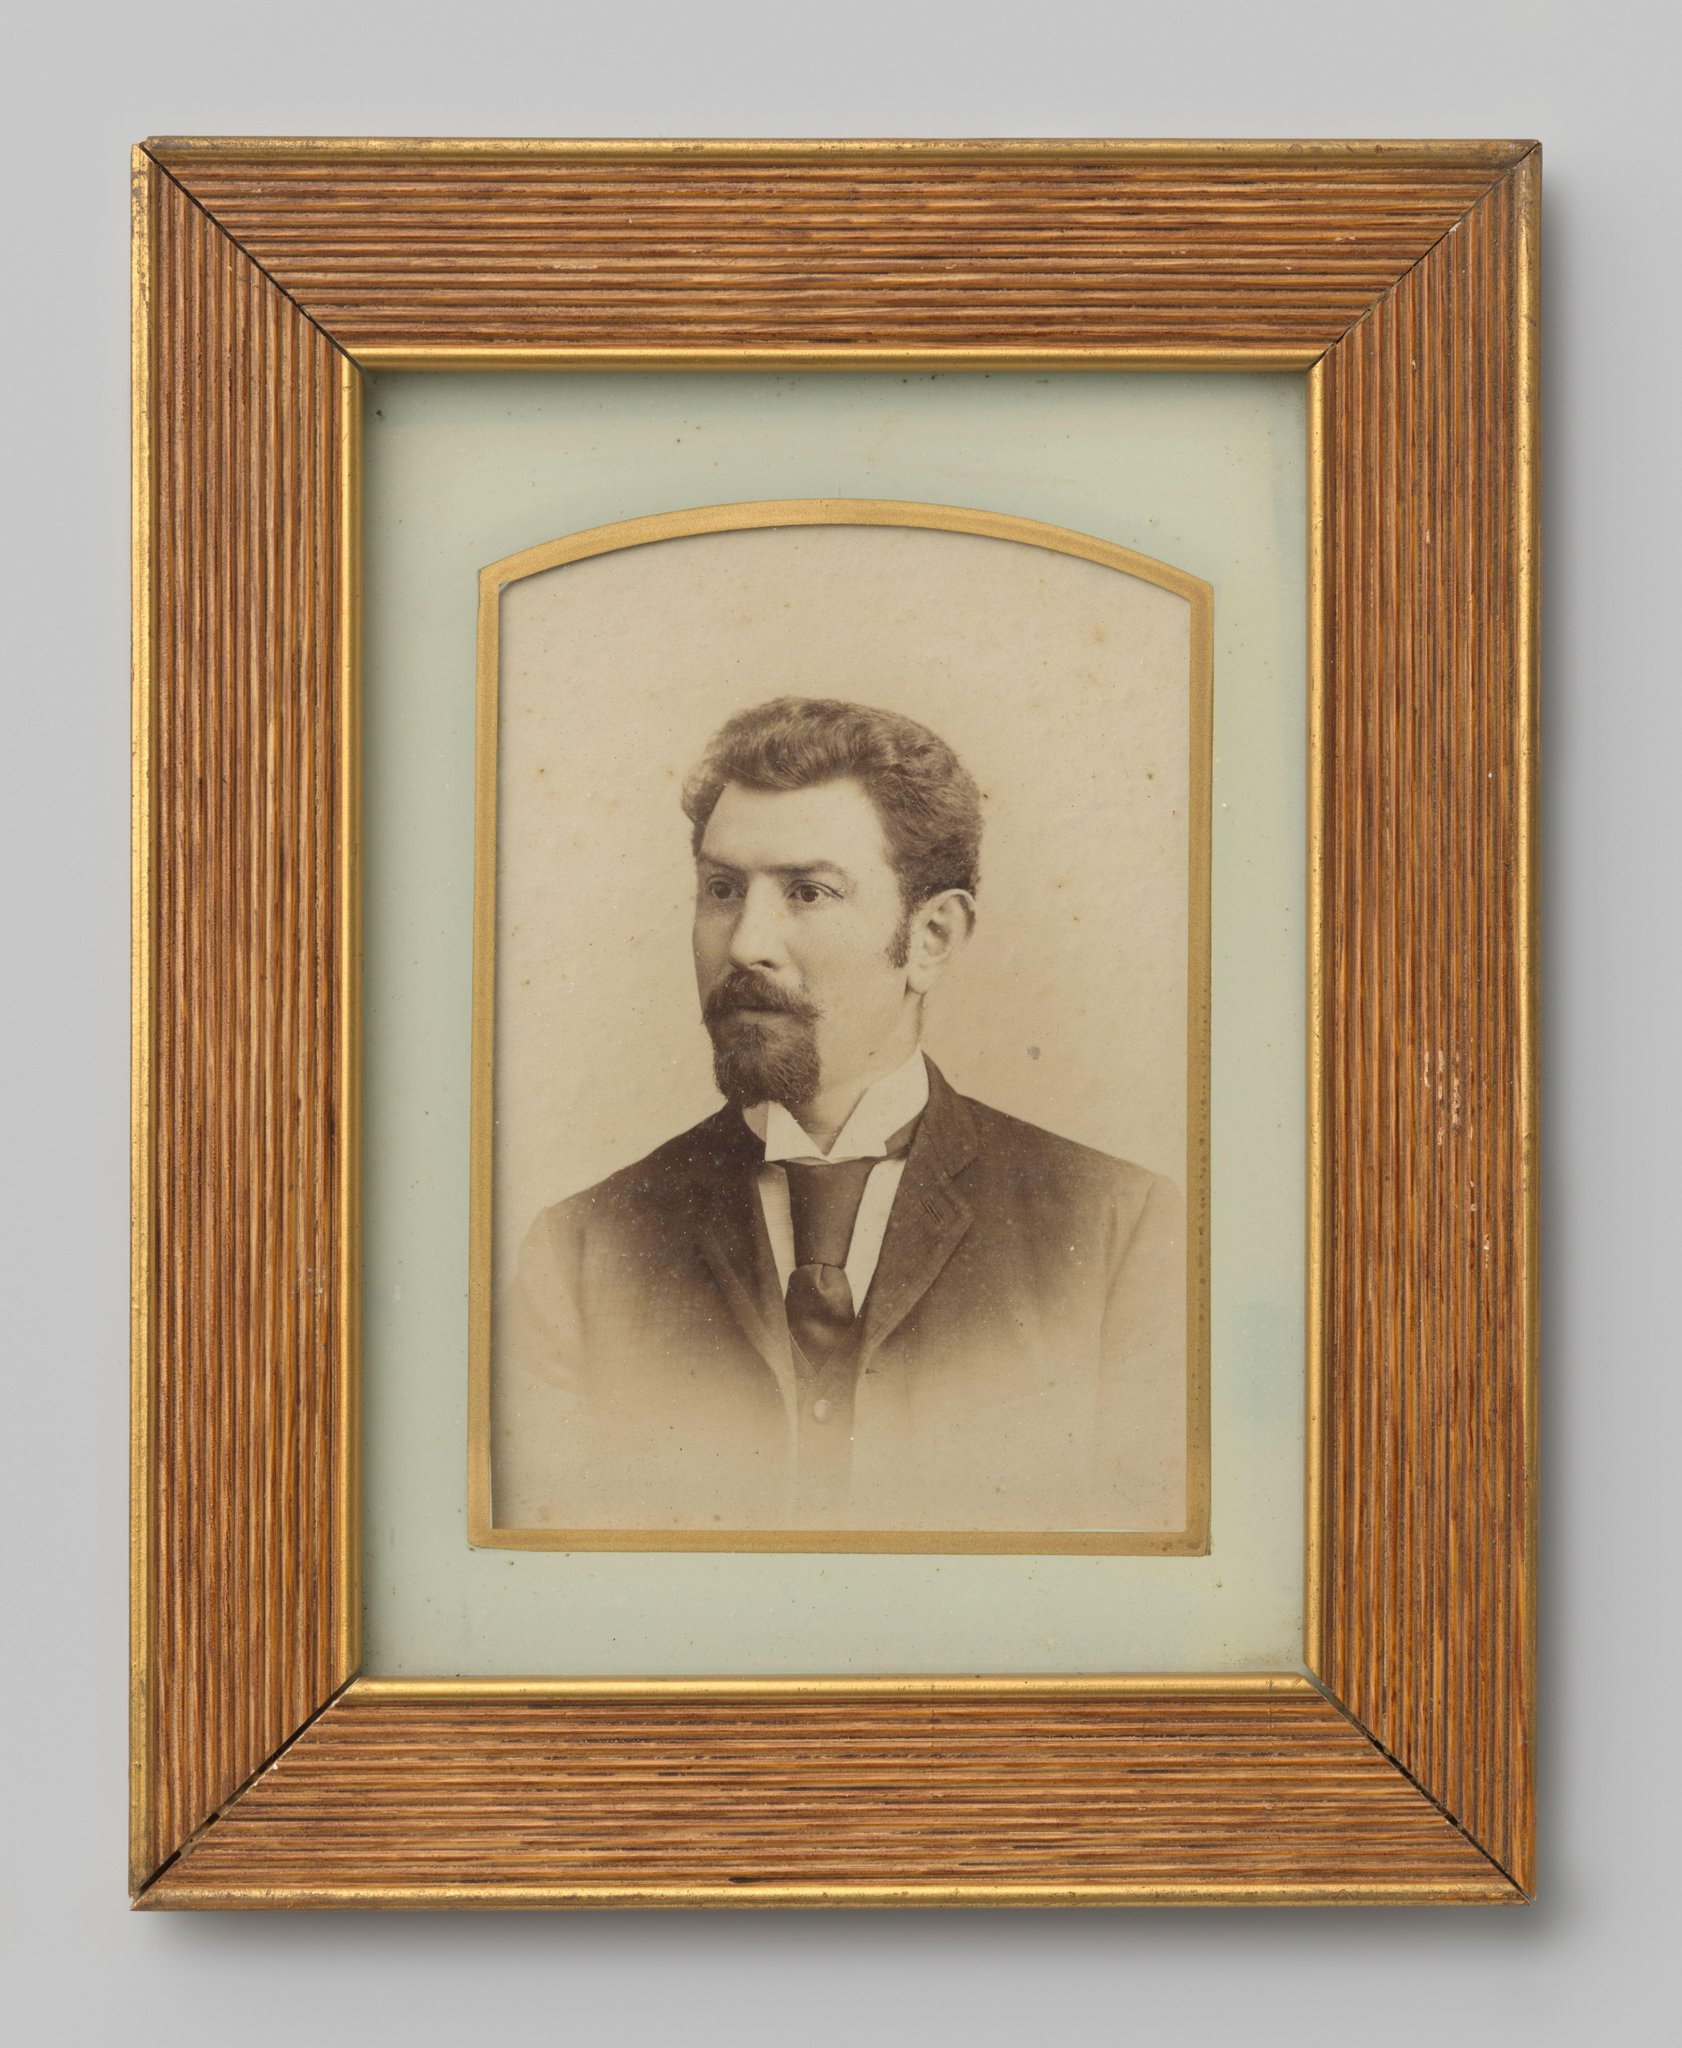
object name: frame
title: Portret van een onbekende man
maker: johannes leonardus van der heijden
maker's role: fotograaf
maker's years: 1856-1937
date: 1880-1910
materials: cardboard, glass, metal, paper, wood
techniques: albumen print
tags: adult man, anonymous historical person portrayed